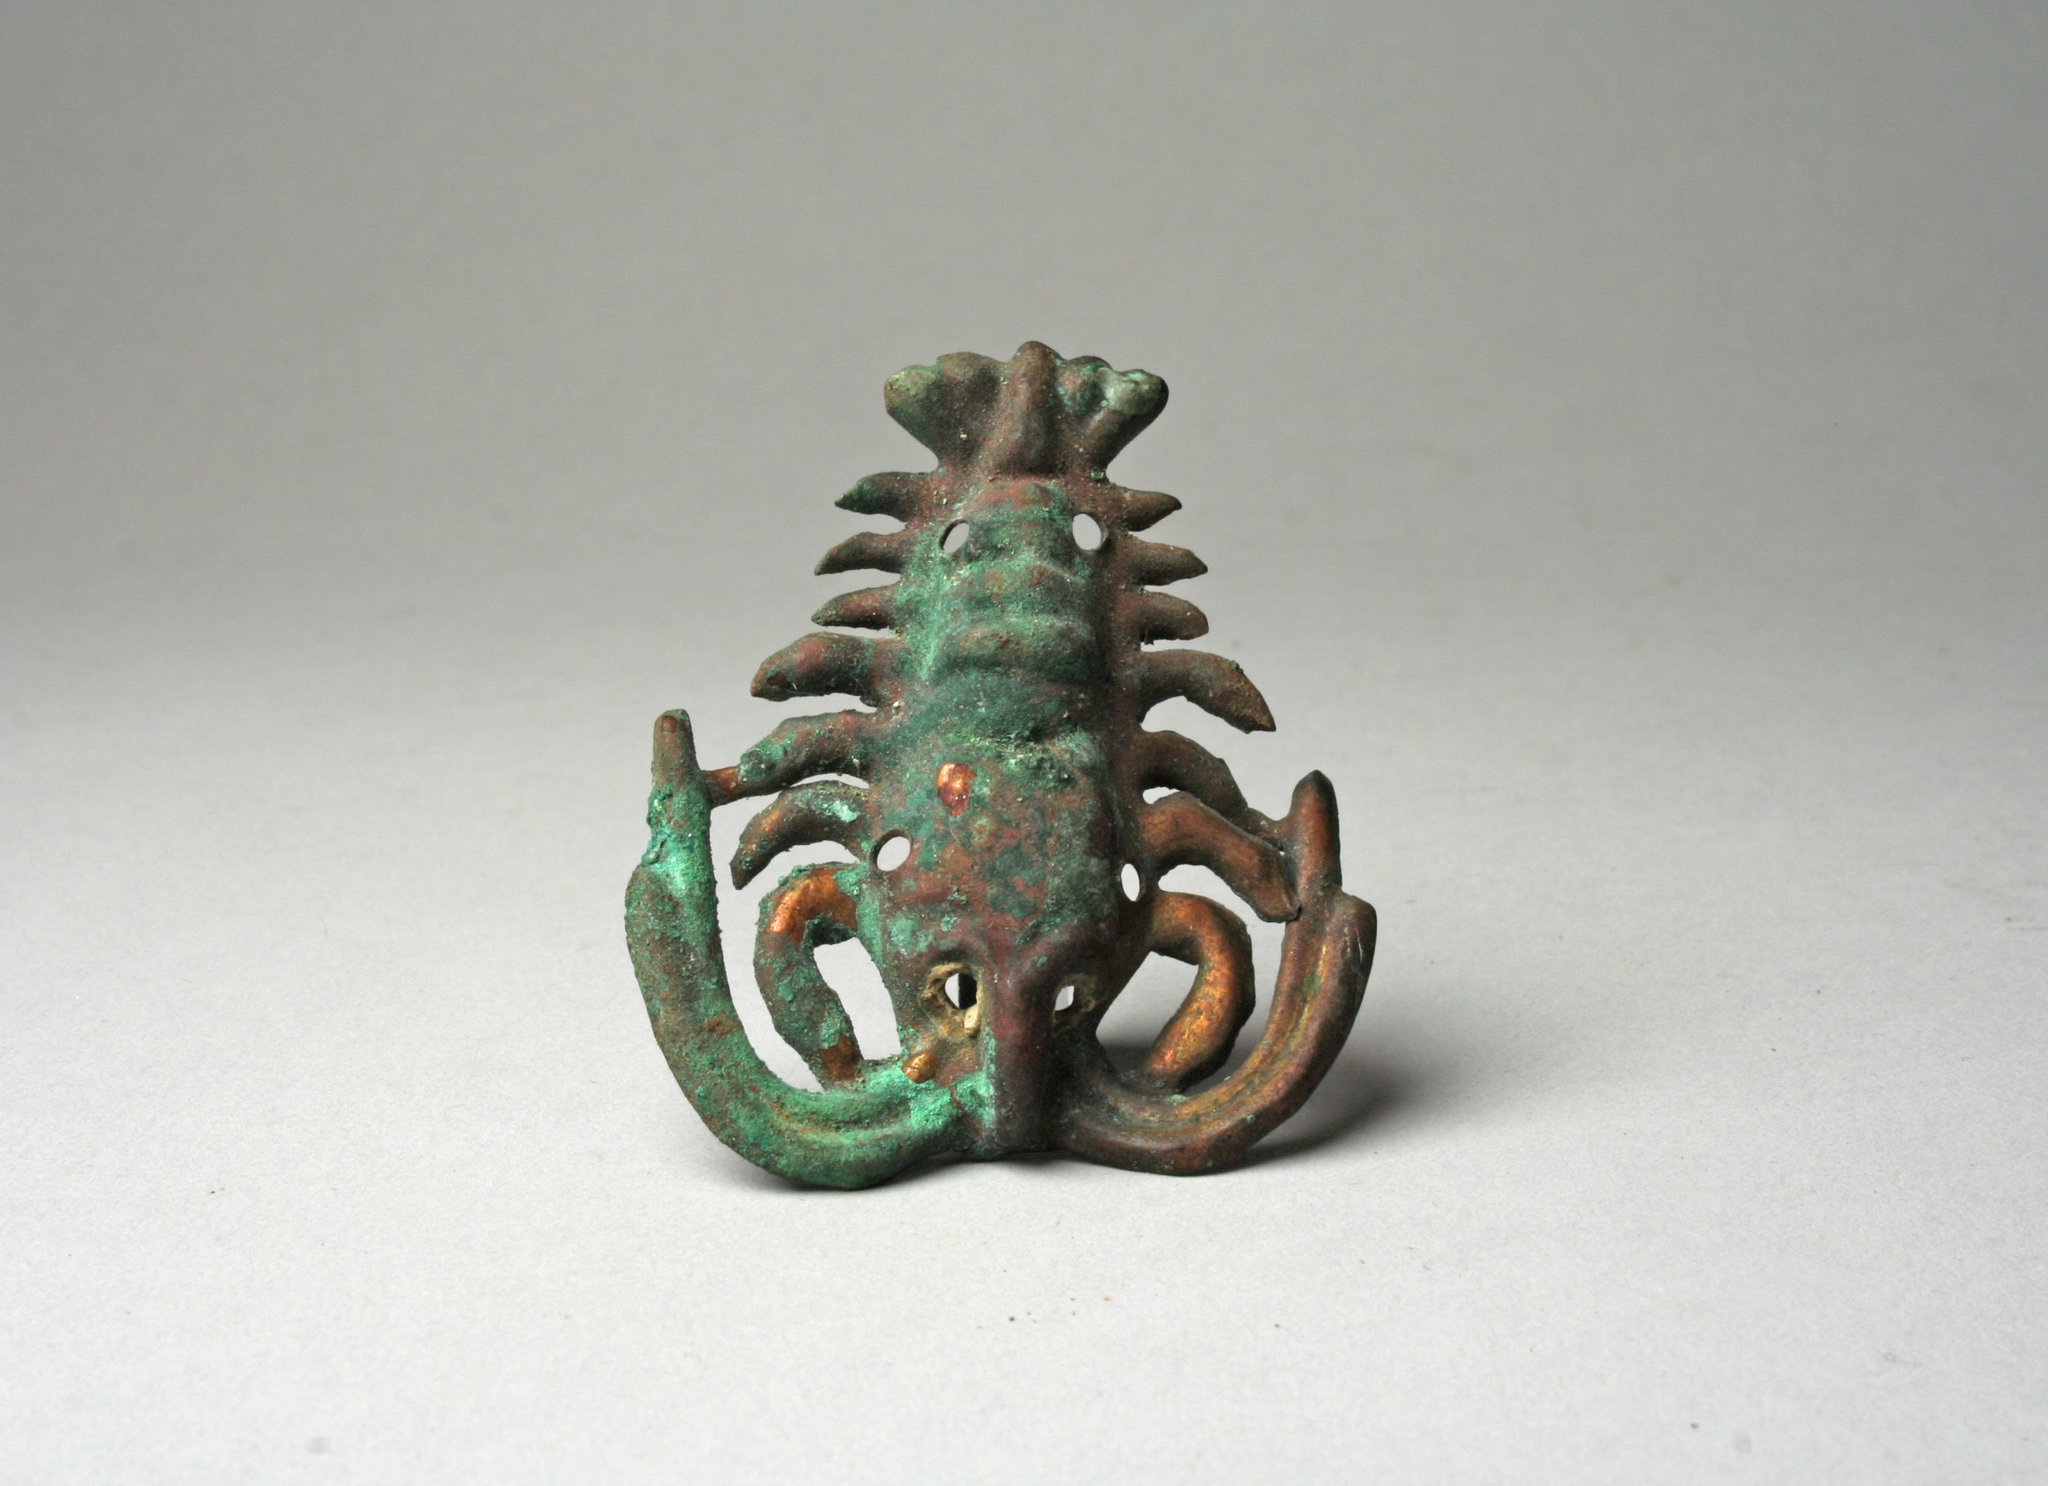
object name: ornament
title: Animal Ornament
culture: moche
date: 501-700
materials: gilt copper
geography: peru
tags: crabs